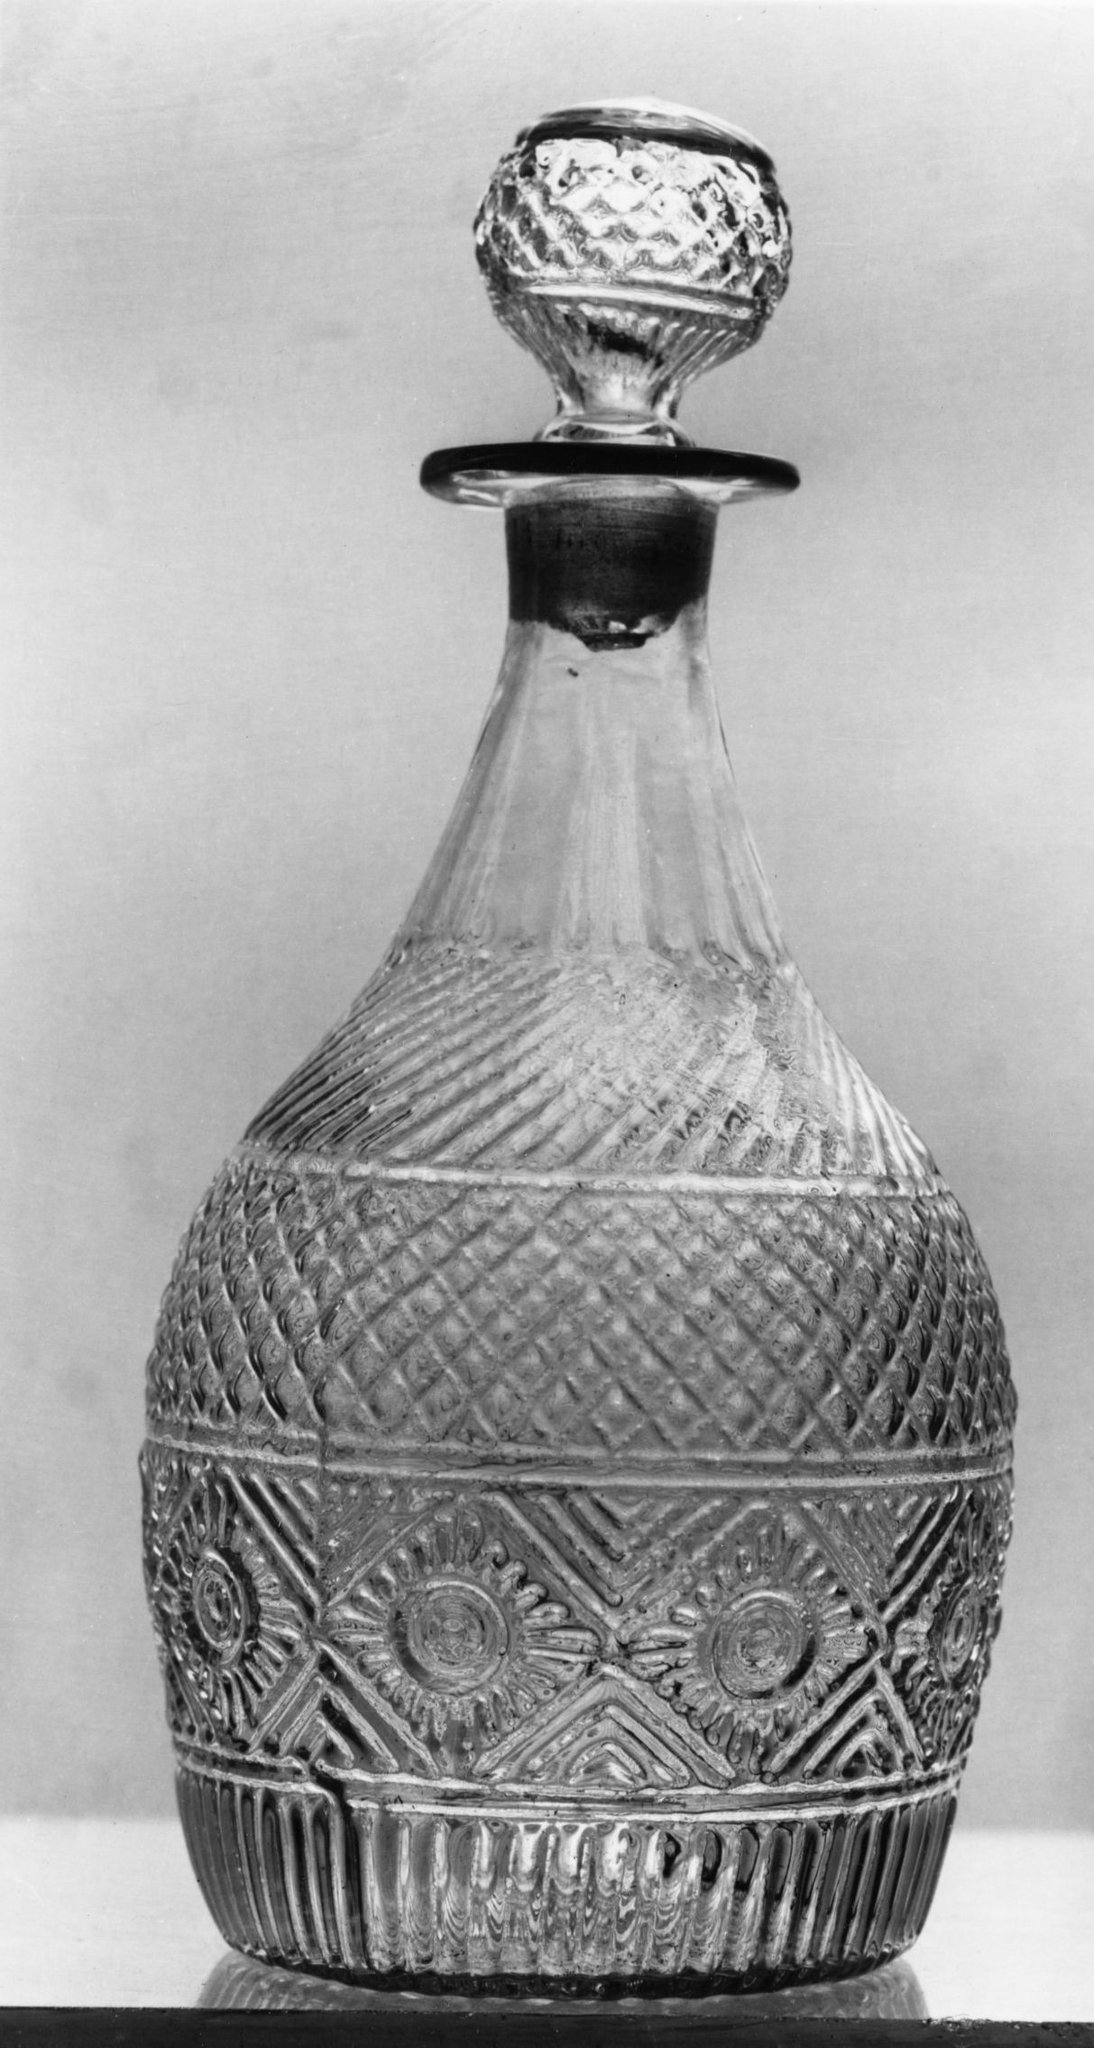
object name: decanter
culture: american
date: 1820-1840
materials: glass, lead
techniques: glassblowing, molding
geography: united states